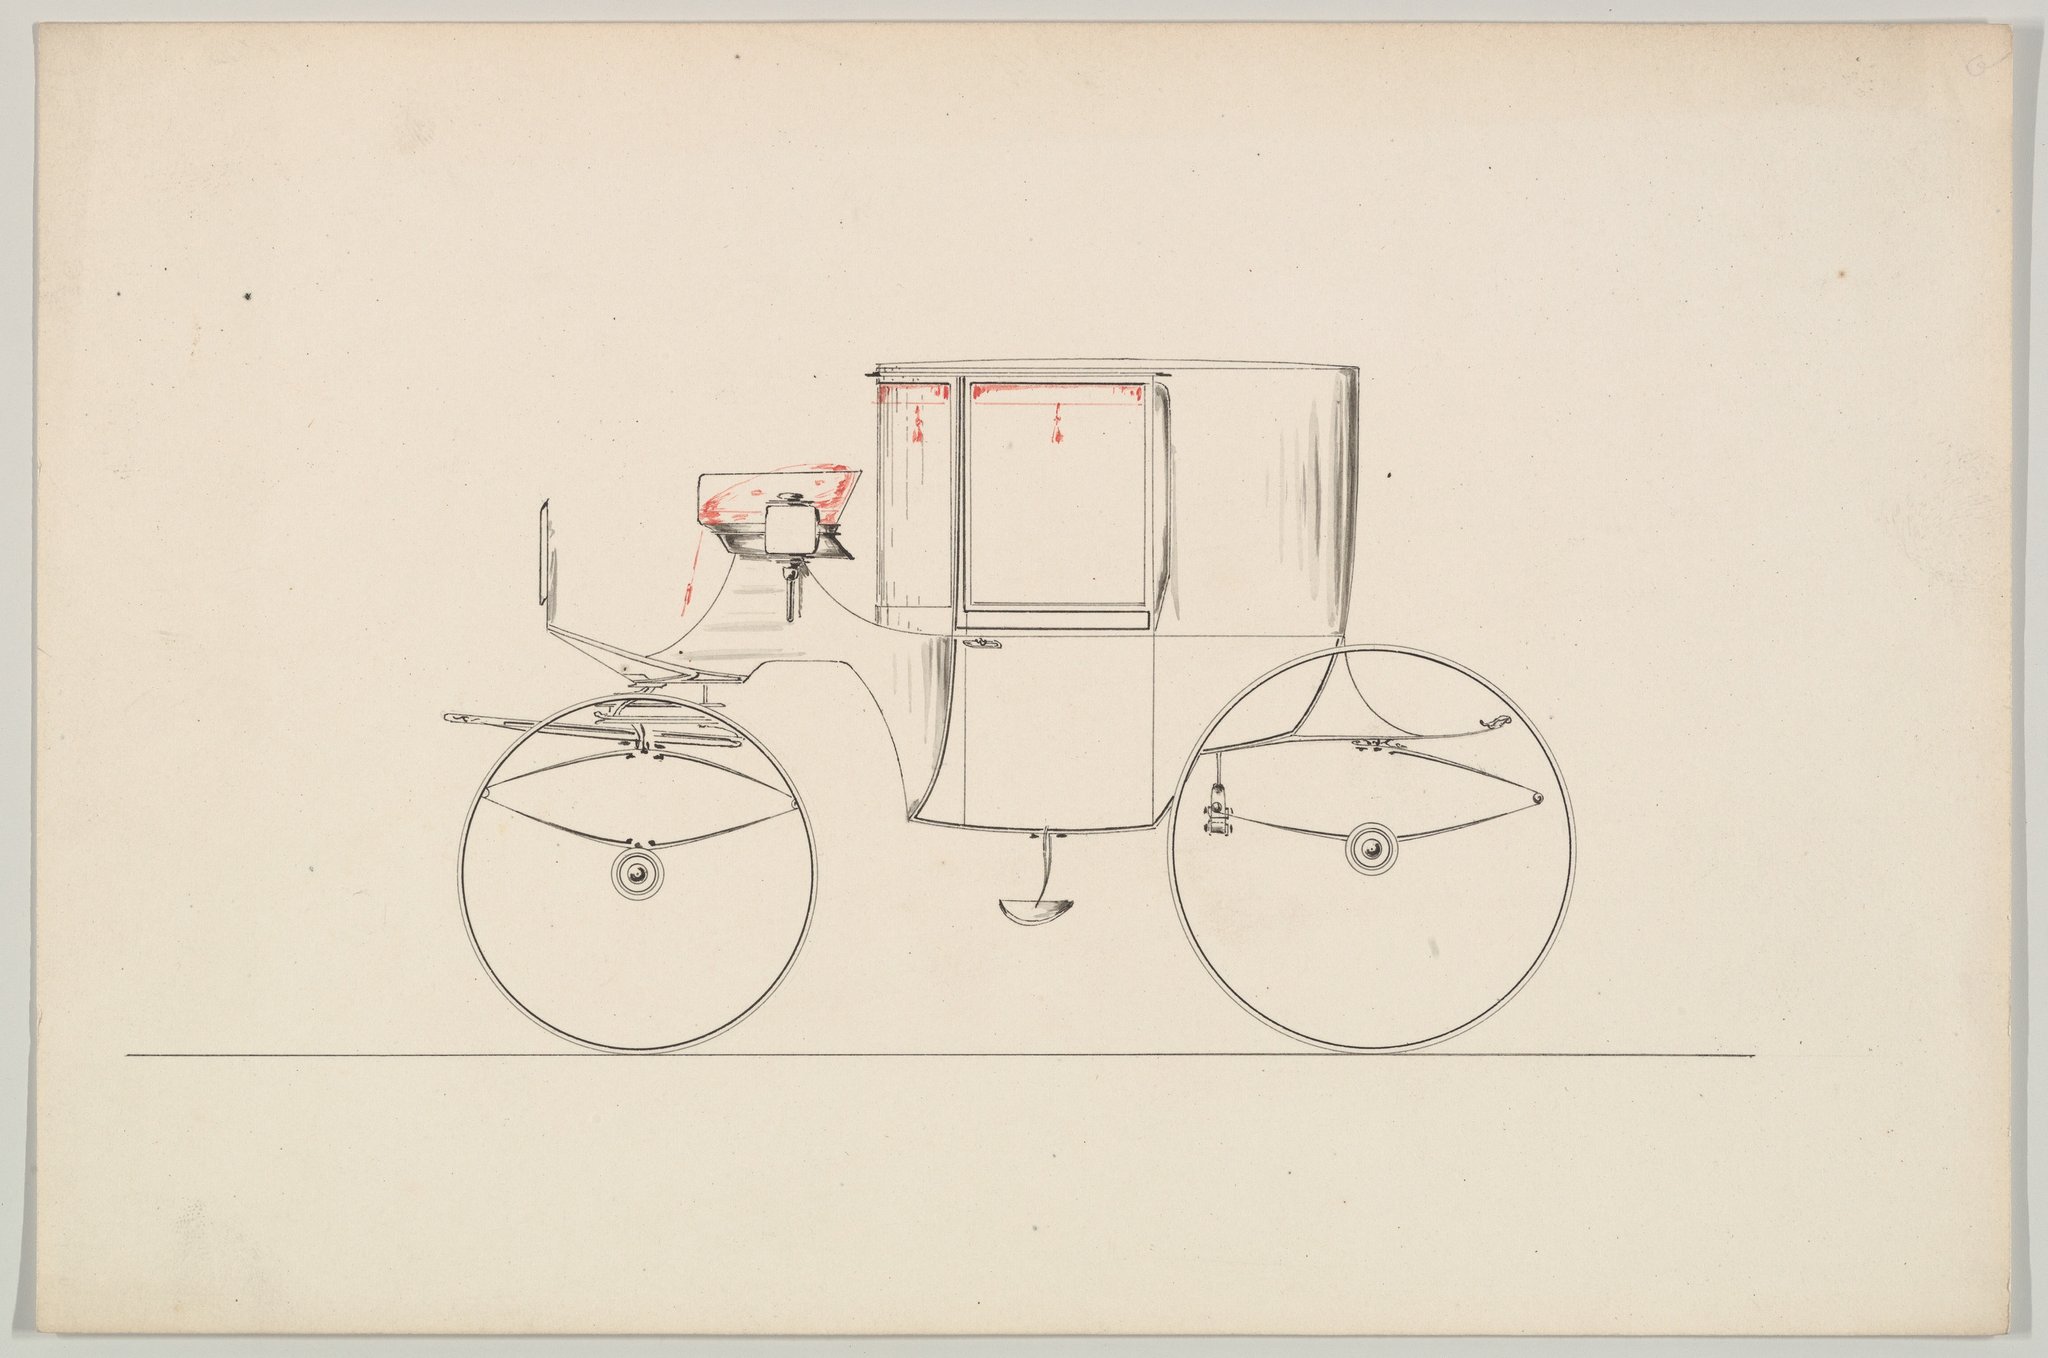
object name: drawing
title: Coupé (unnumbered)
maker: brewster & co.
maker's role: manufacturer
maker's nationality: american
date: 1850-1870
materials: ink, watercolor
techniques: pen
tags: carriages